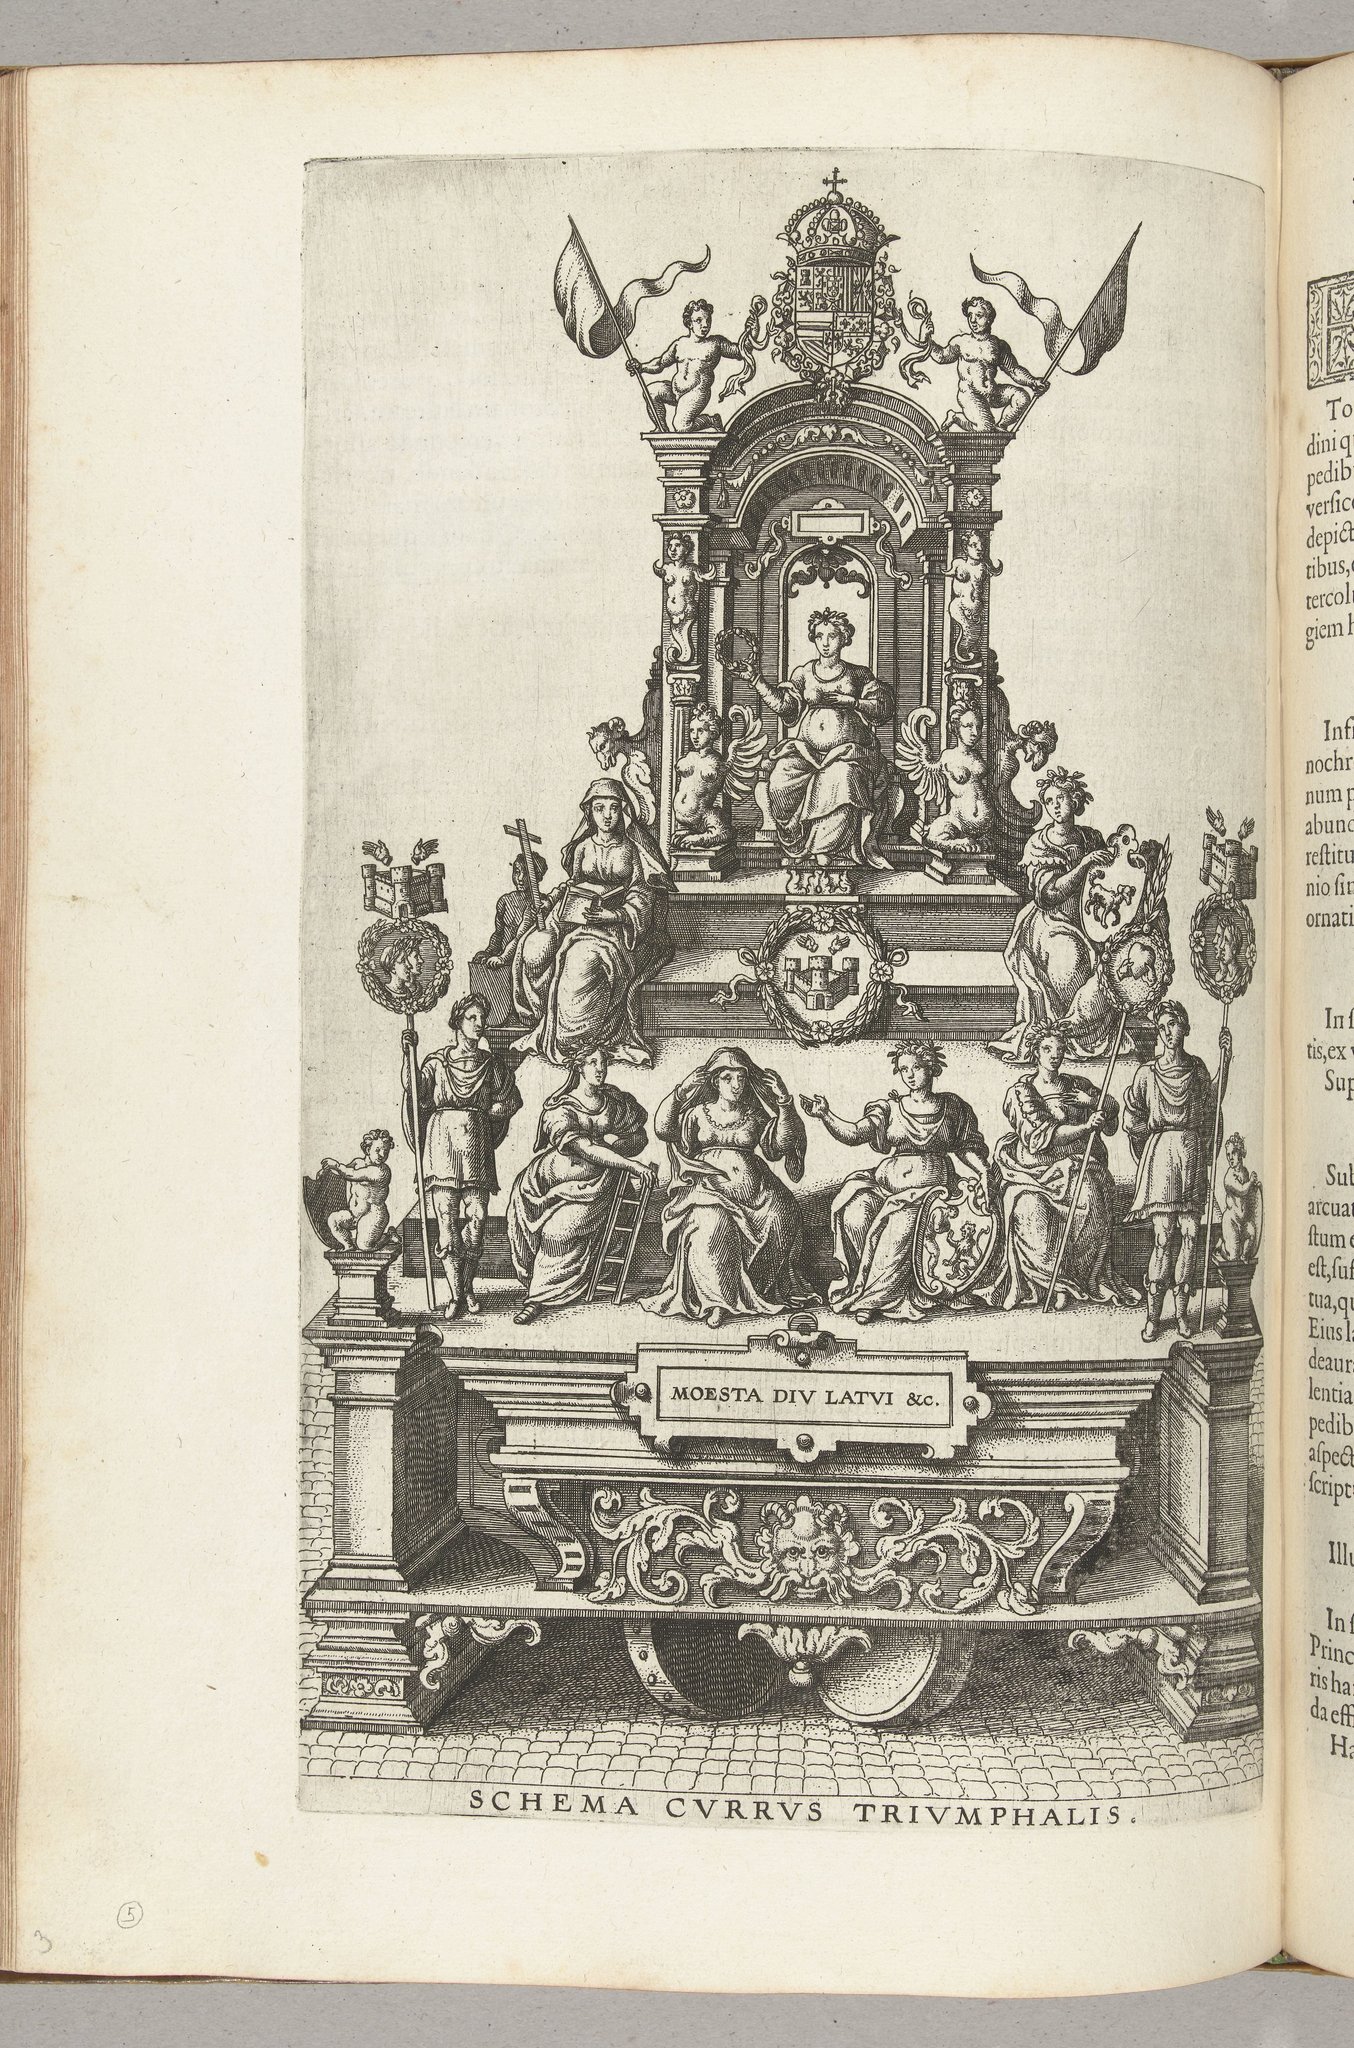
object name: print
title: Schema Currus triumphalis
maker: pieter van der borcht (i)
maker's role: print maker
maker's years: 1545-1608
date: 1594-1595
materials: paper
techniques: etching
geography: antwerp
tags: vienna, personification of a city, town-patron(ess), triumphal entry and public reception, pageant, 'entrée solennelle', 'joyeuse entrée', antwerp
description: Toneel in de vorm van een triomfwagen met de Antwerpse stedenmaagd omringd door deugden. Opgericht op de Mechelse Plein. Onderdeel van de beschrijving van de intocht van aartshertog Ernst te Antwerpen, 18 juli 1594, door Joannes Bochius, Descriptio publicae gratulationis, spectaculorum et ludorum, in adventu Sereniss. Principis Ernesti Archiducis Austriae, Ex Officina Plantiniana, Antwerpen 1595.